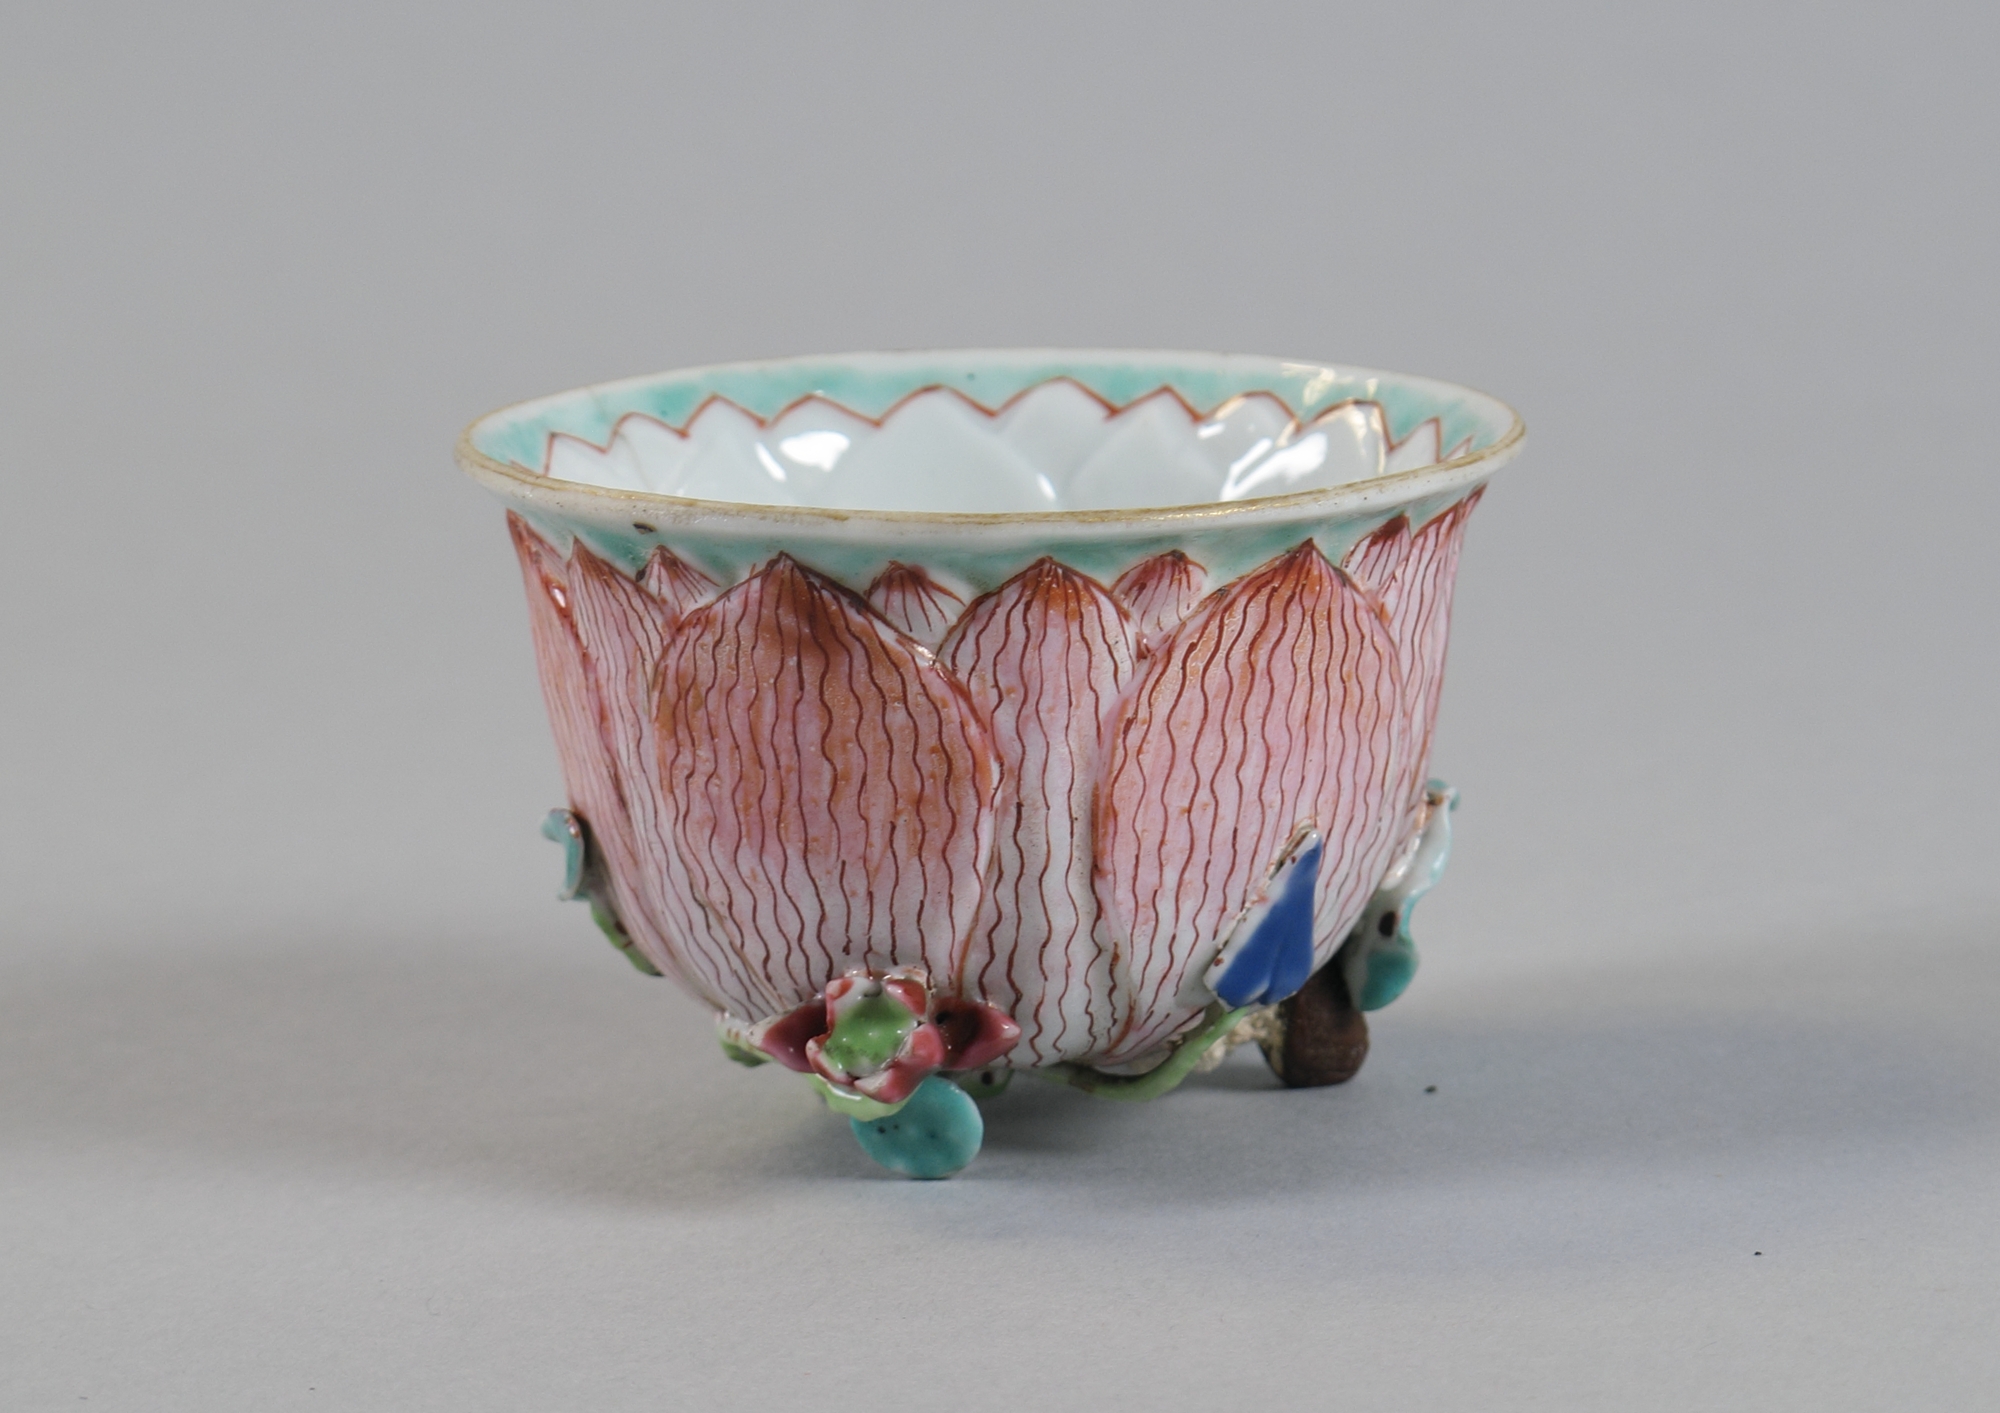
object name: cup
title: Lotus cup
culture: chinese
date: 1767-1800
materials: enamel, porcelain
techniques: overglaze, painting, polychrome